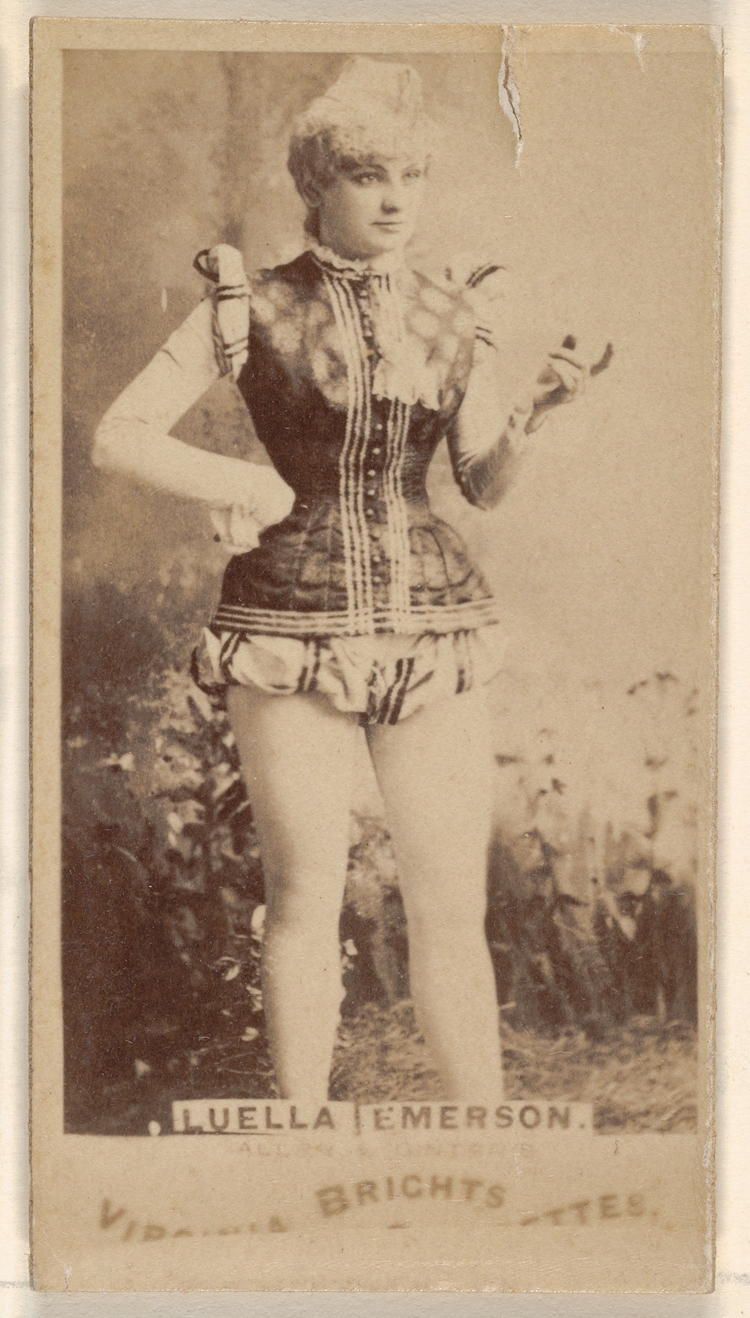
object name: photograph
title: Luella Emerson, from the Actors and Actresses series (N45, Type 1) for Virginia Brights Cigarettes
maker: allen & ginter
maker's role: publisher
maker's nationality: american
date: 1888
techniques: albumen silver print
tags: portraits,women,actresses